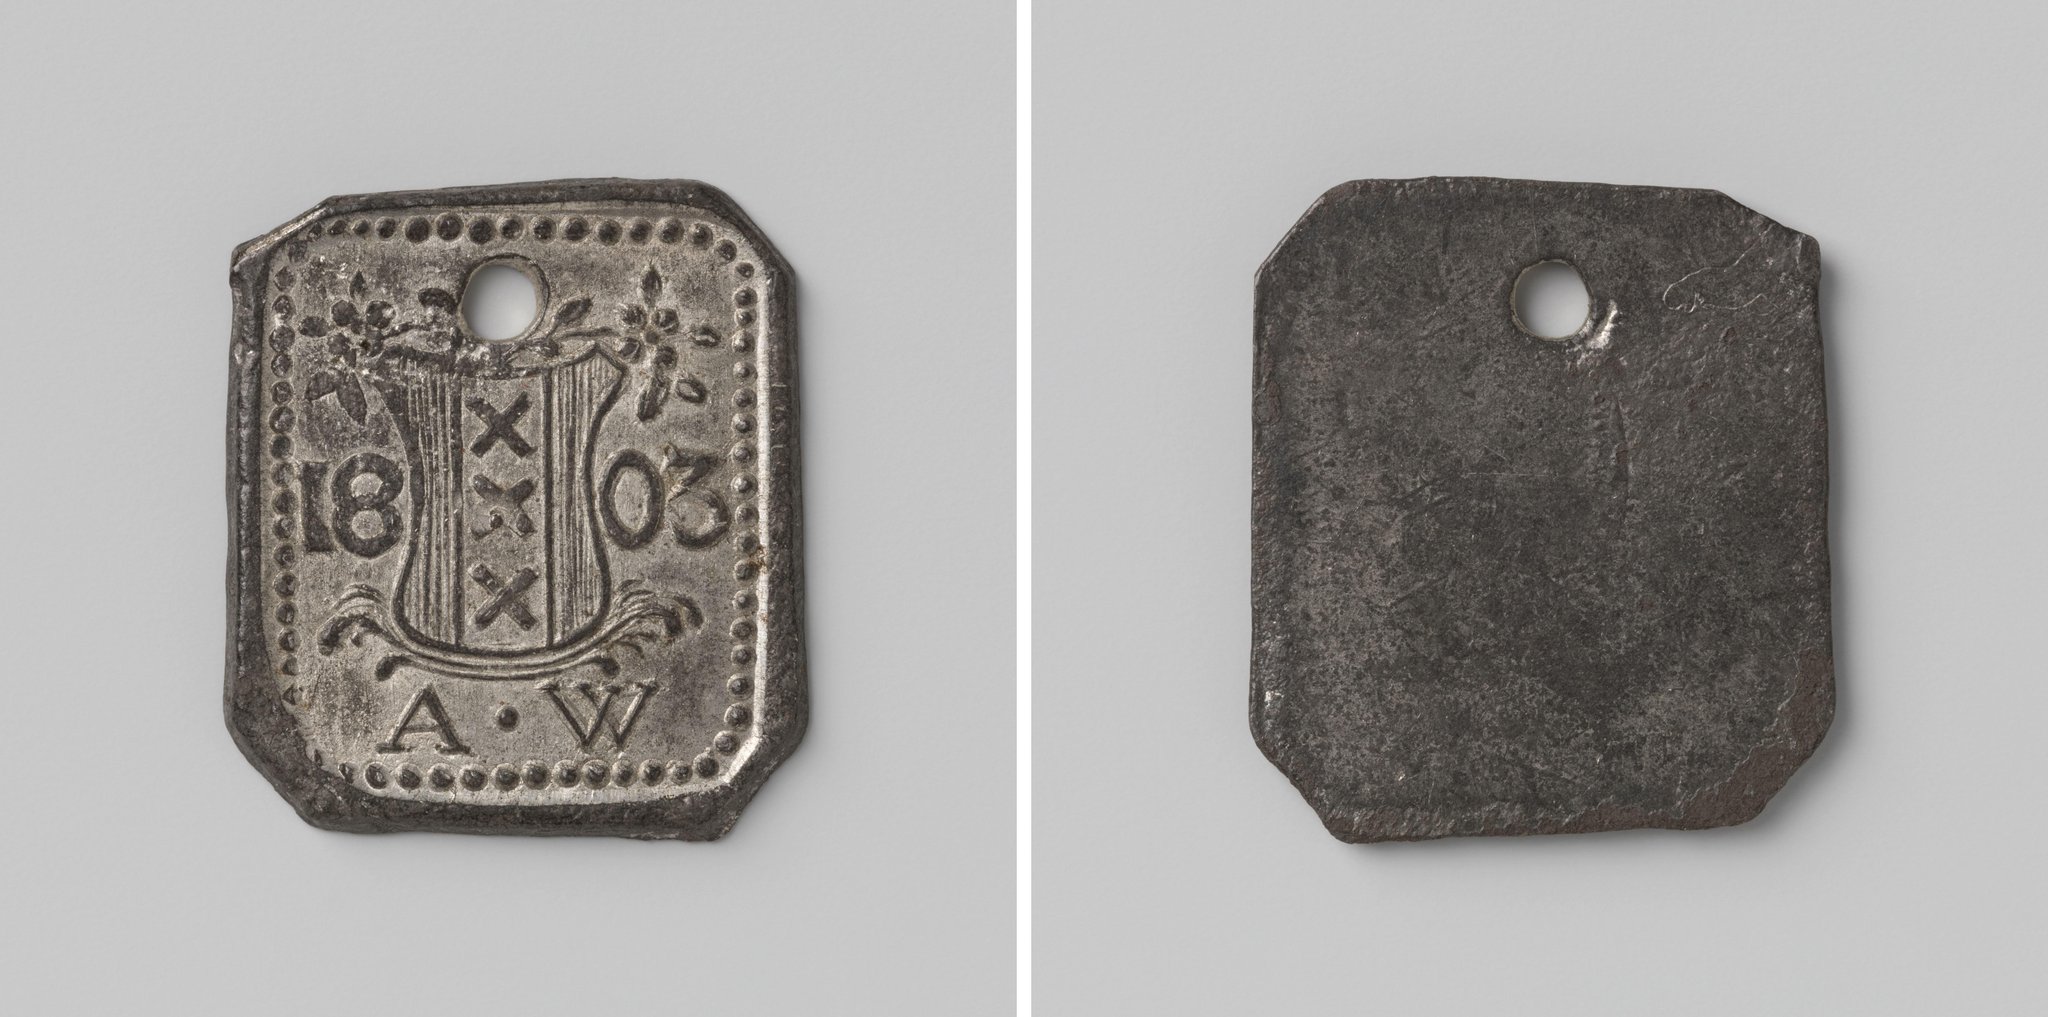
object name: hondenbelastingloodje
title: Aalmoezeniersweeshuis te Amsterdam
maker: Anonymous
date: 1803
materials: tin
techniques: striking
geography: amsterdam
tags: amsterdam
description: eenzijdig, rechthoekig loodje met gat erin. Voorzijde: wapenschild, omgeven door bladertakjes tussen jaartal boven opschrift AW. Keerzijde: blanco